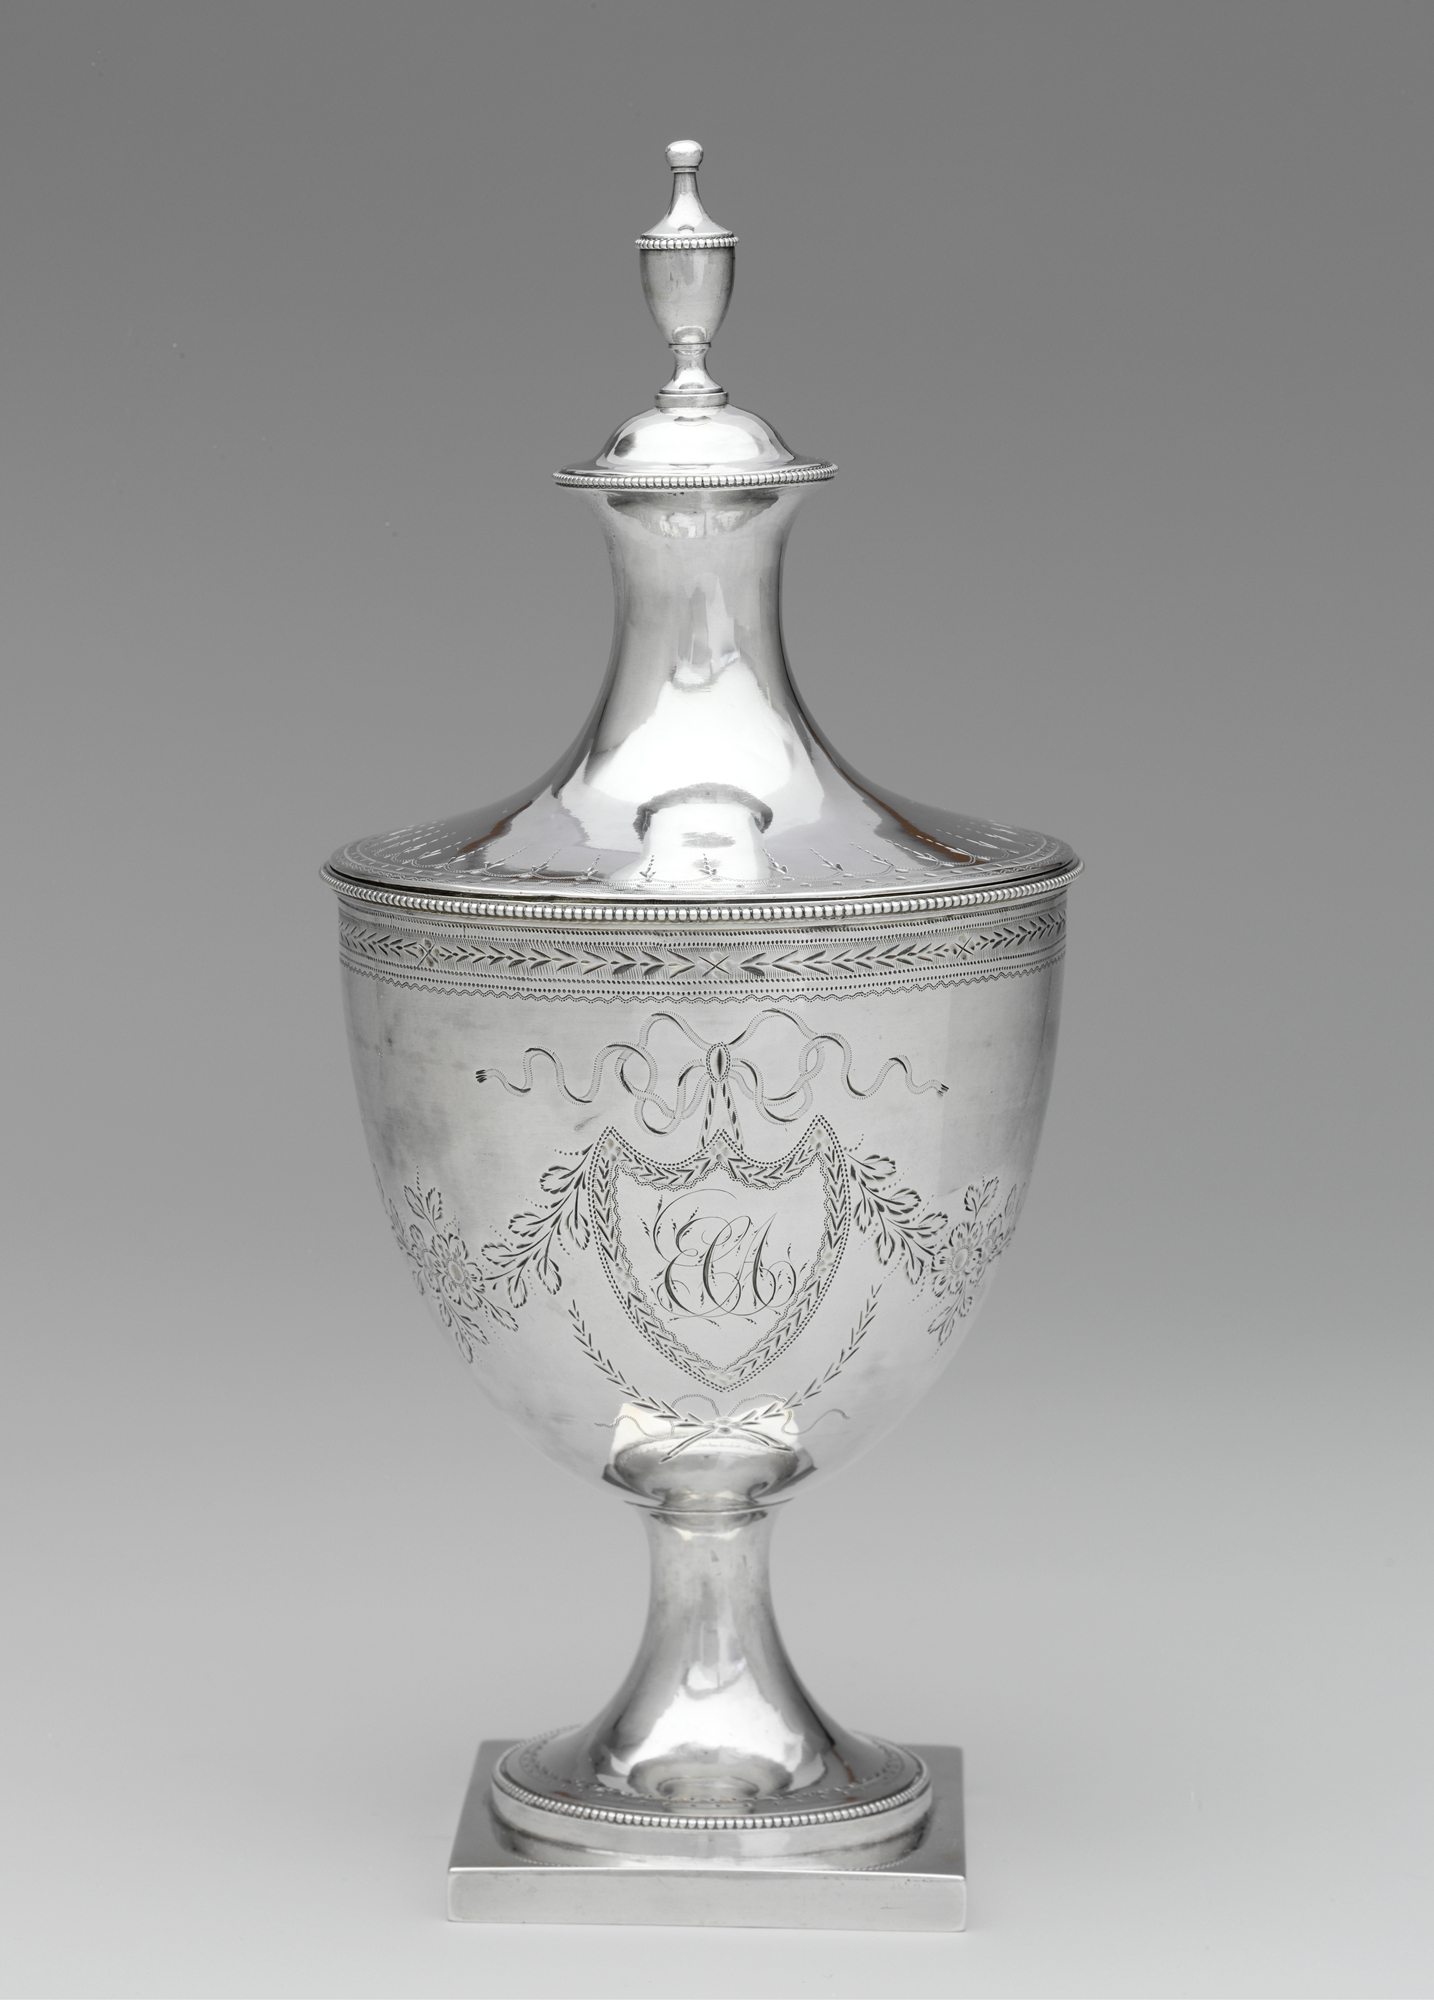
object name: sugar bowl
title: Covered sugar bowl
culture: american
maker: william w. gilbert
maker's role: maker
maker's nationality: american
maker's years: 1746-1832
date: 1790-1800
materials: silver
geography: united states